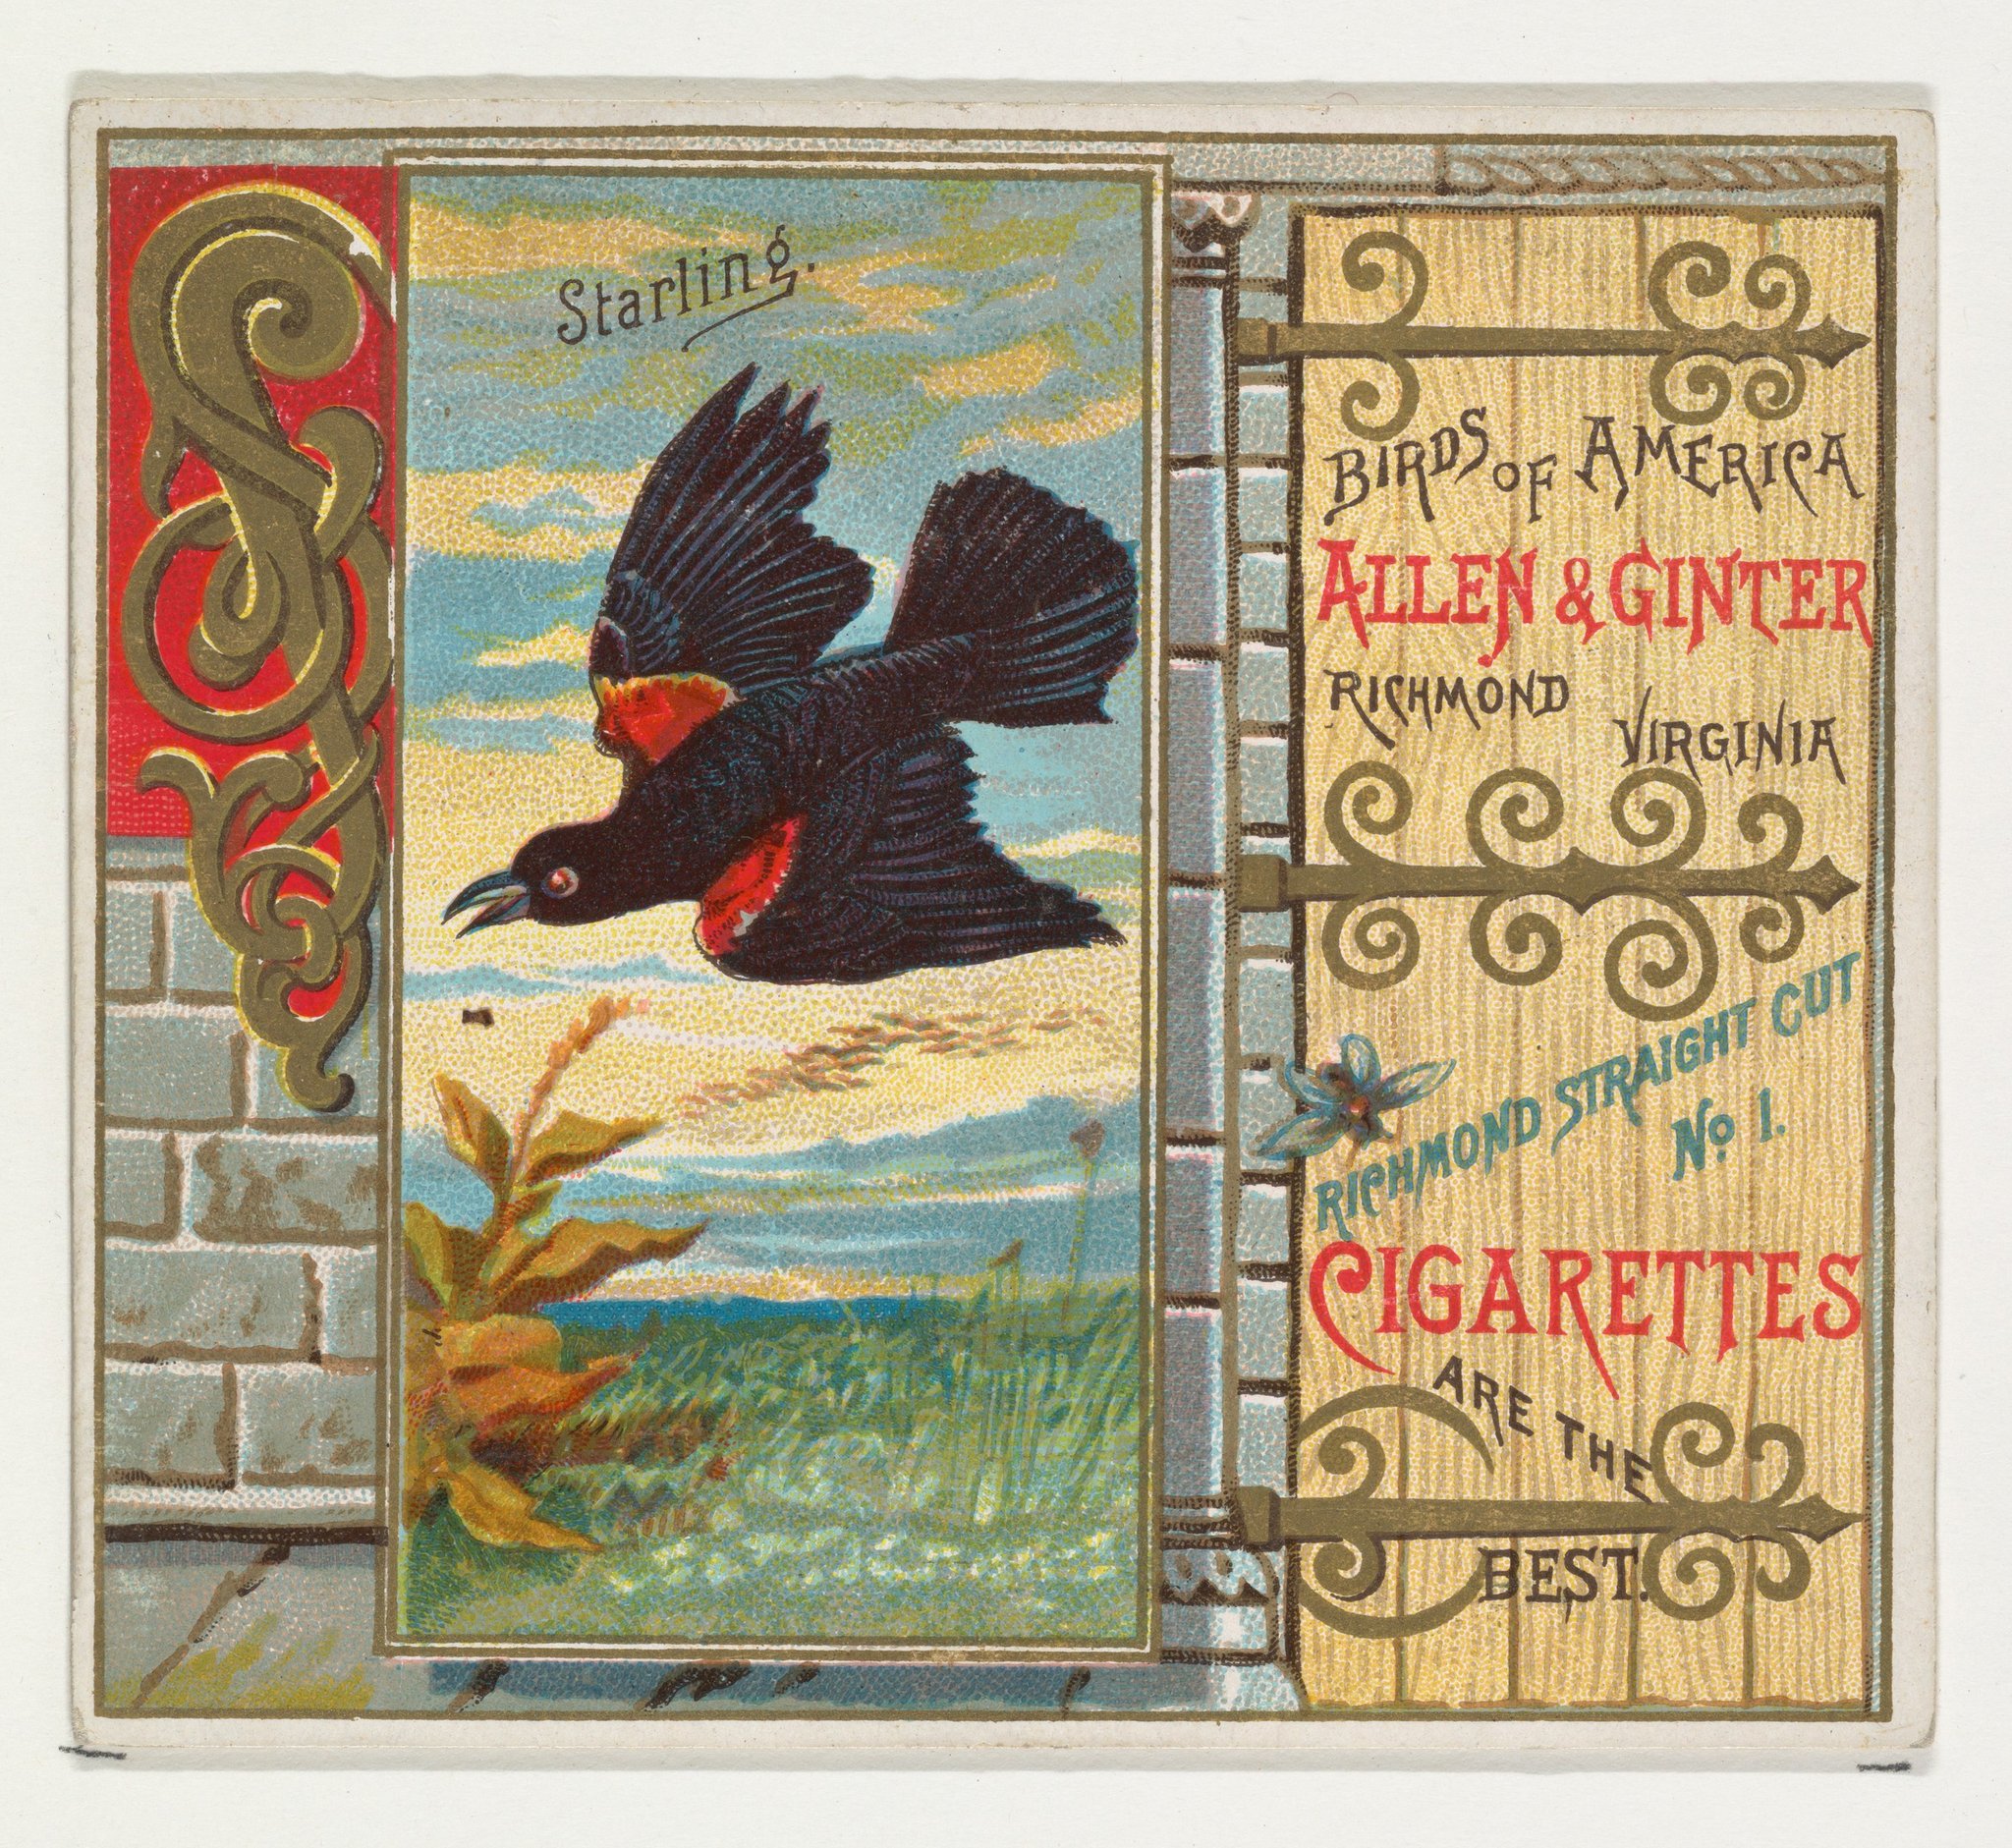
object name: print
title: Starling, from the Birds of America series (N37) for Allen & Ginter Cigarettes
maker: allen & ginter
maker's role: publisher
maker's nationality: american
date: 1888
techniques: color lithograph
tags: birds